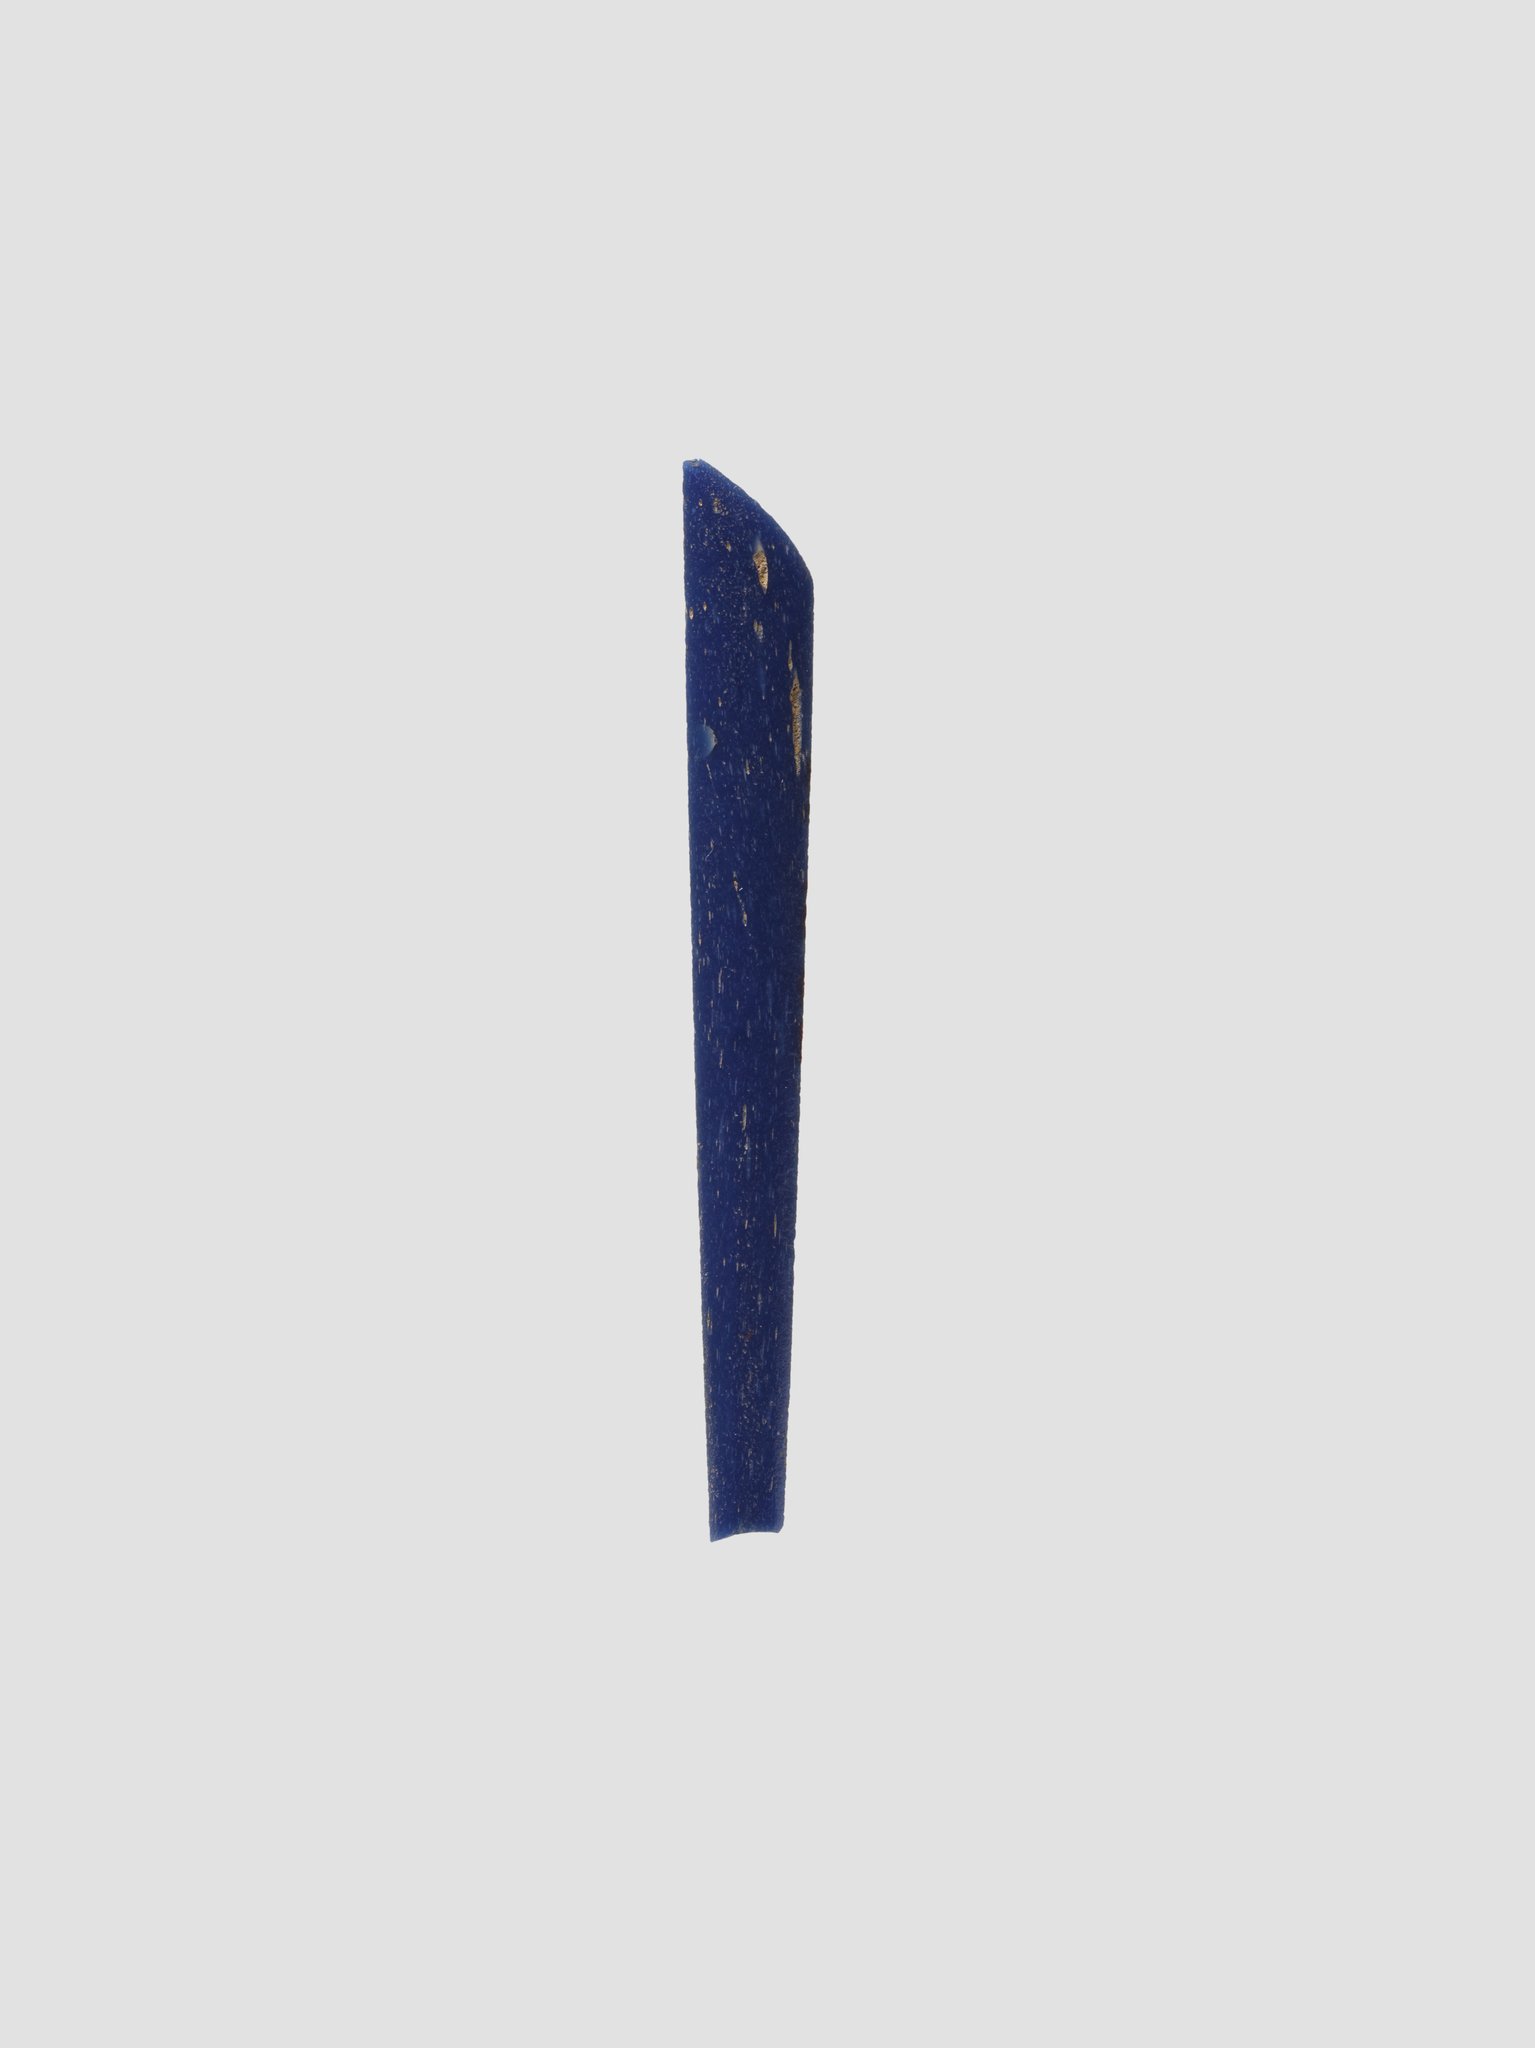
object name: inlay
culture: assyrian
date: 800-601 BCE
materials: glass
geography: mesopotamia